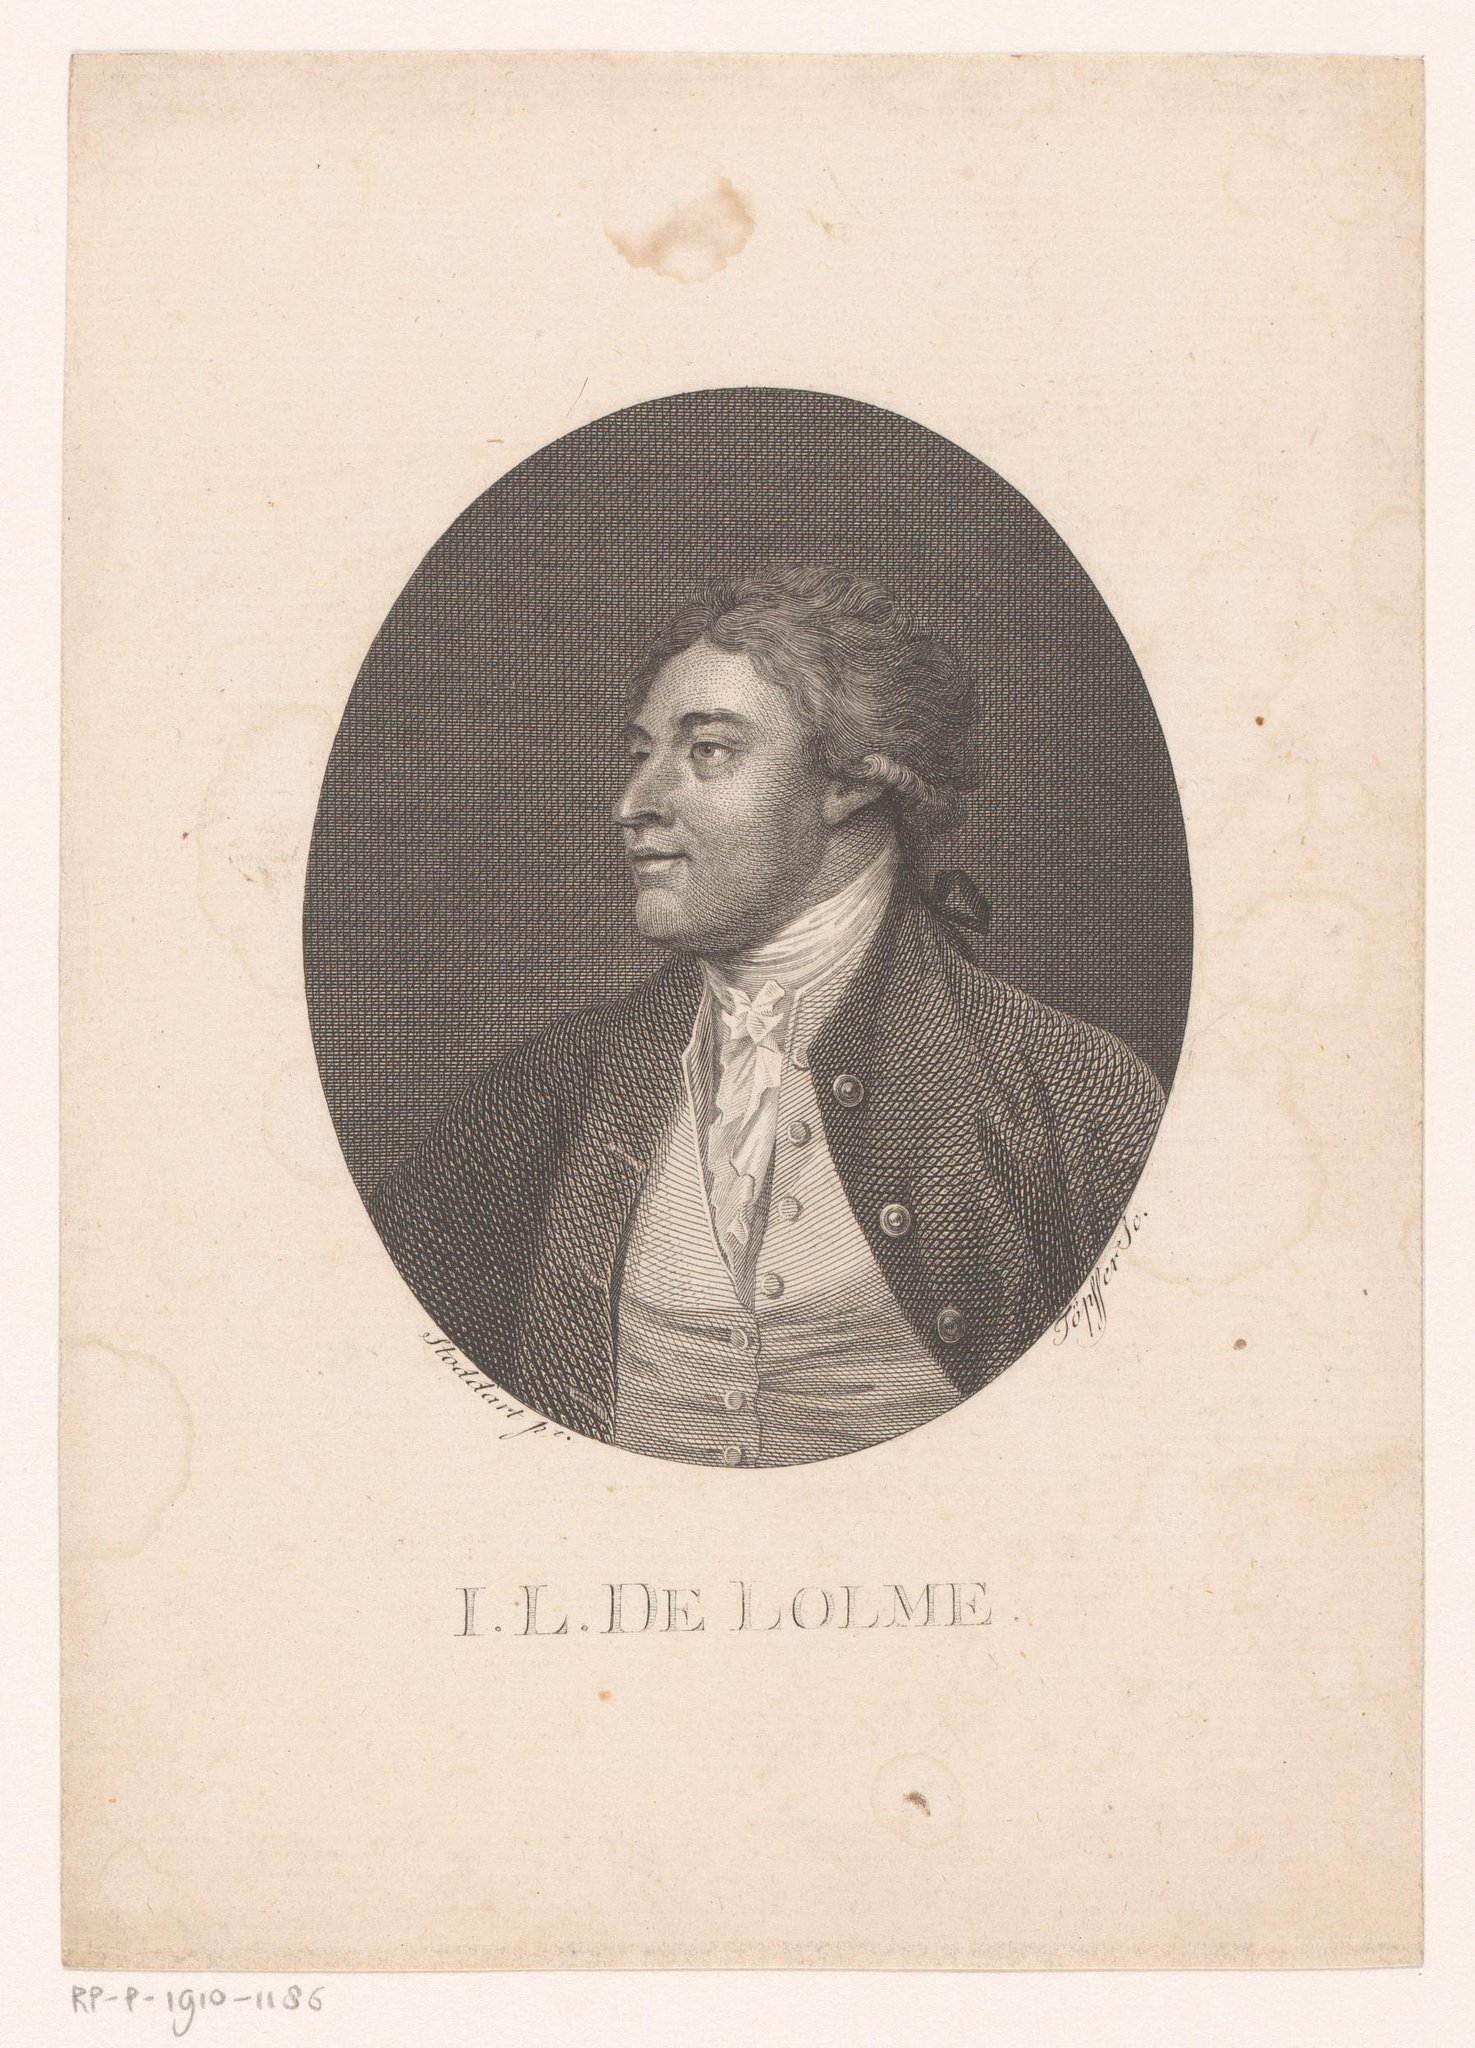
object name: print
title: Portret van Jean Louis de Lolme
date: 1776-1847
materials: paper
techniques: engraving, etching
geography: switzerland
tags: historical persons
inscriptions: collector's mark: Lugt 2228